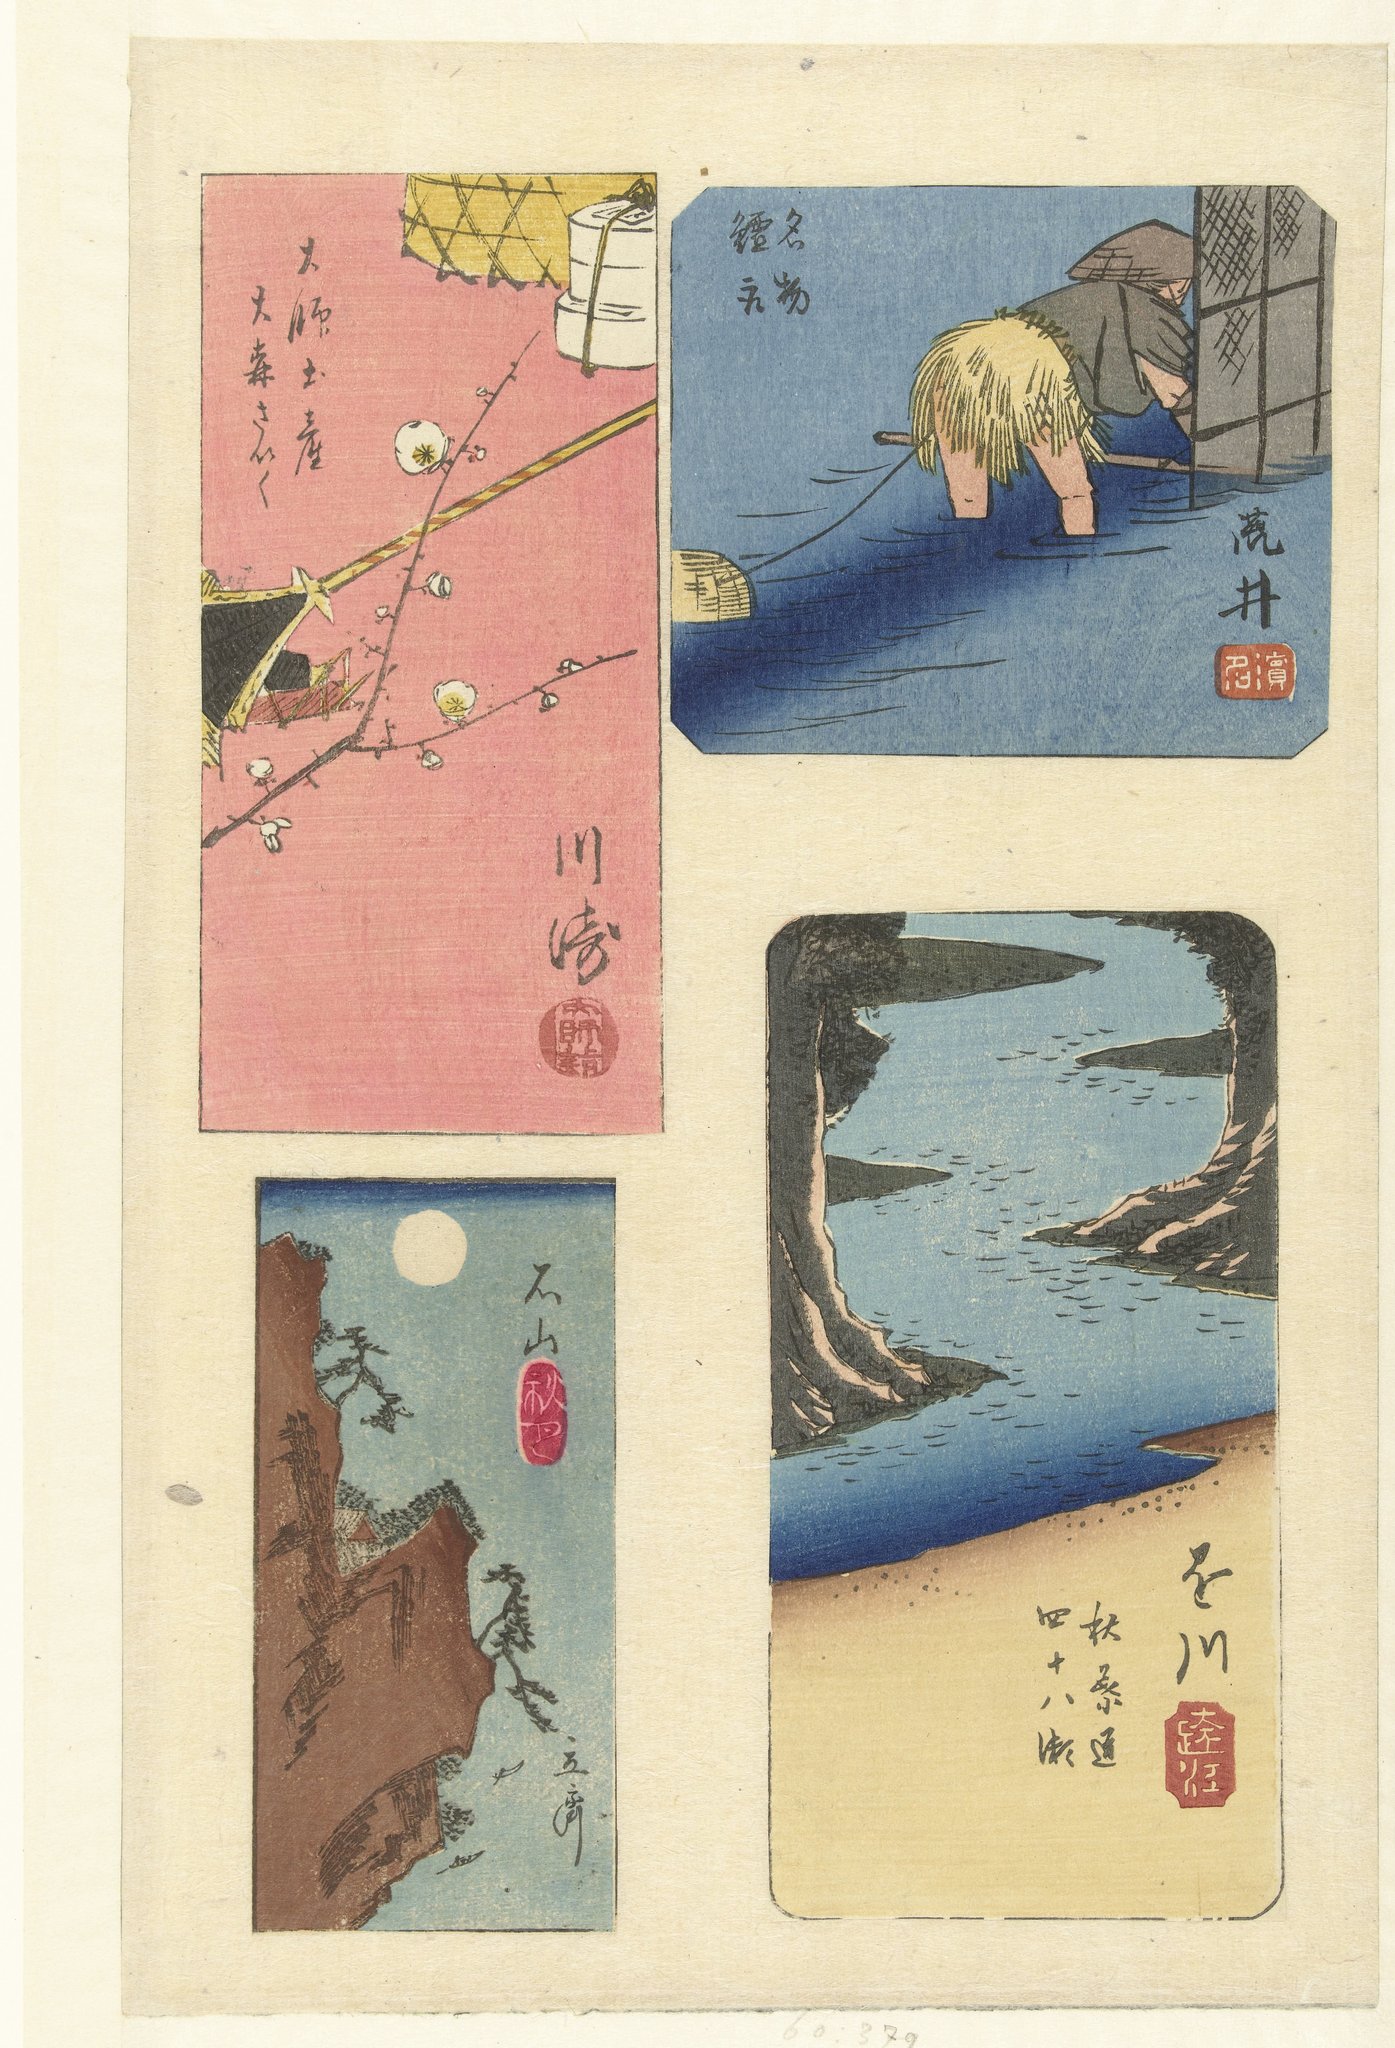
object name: print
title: Vier harimaze van beroemde plaatsen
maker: utagawa hiroshige (i)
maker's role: draughtsman, print maker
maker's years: 1797-1858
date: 1848-1852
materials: paper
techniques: woodcut, nishiki e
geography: japan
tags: flowers, landscapes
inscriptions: collector's mark: Lugt 2228